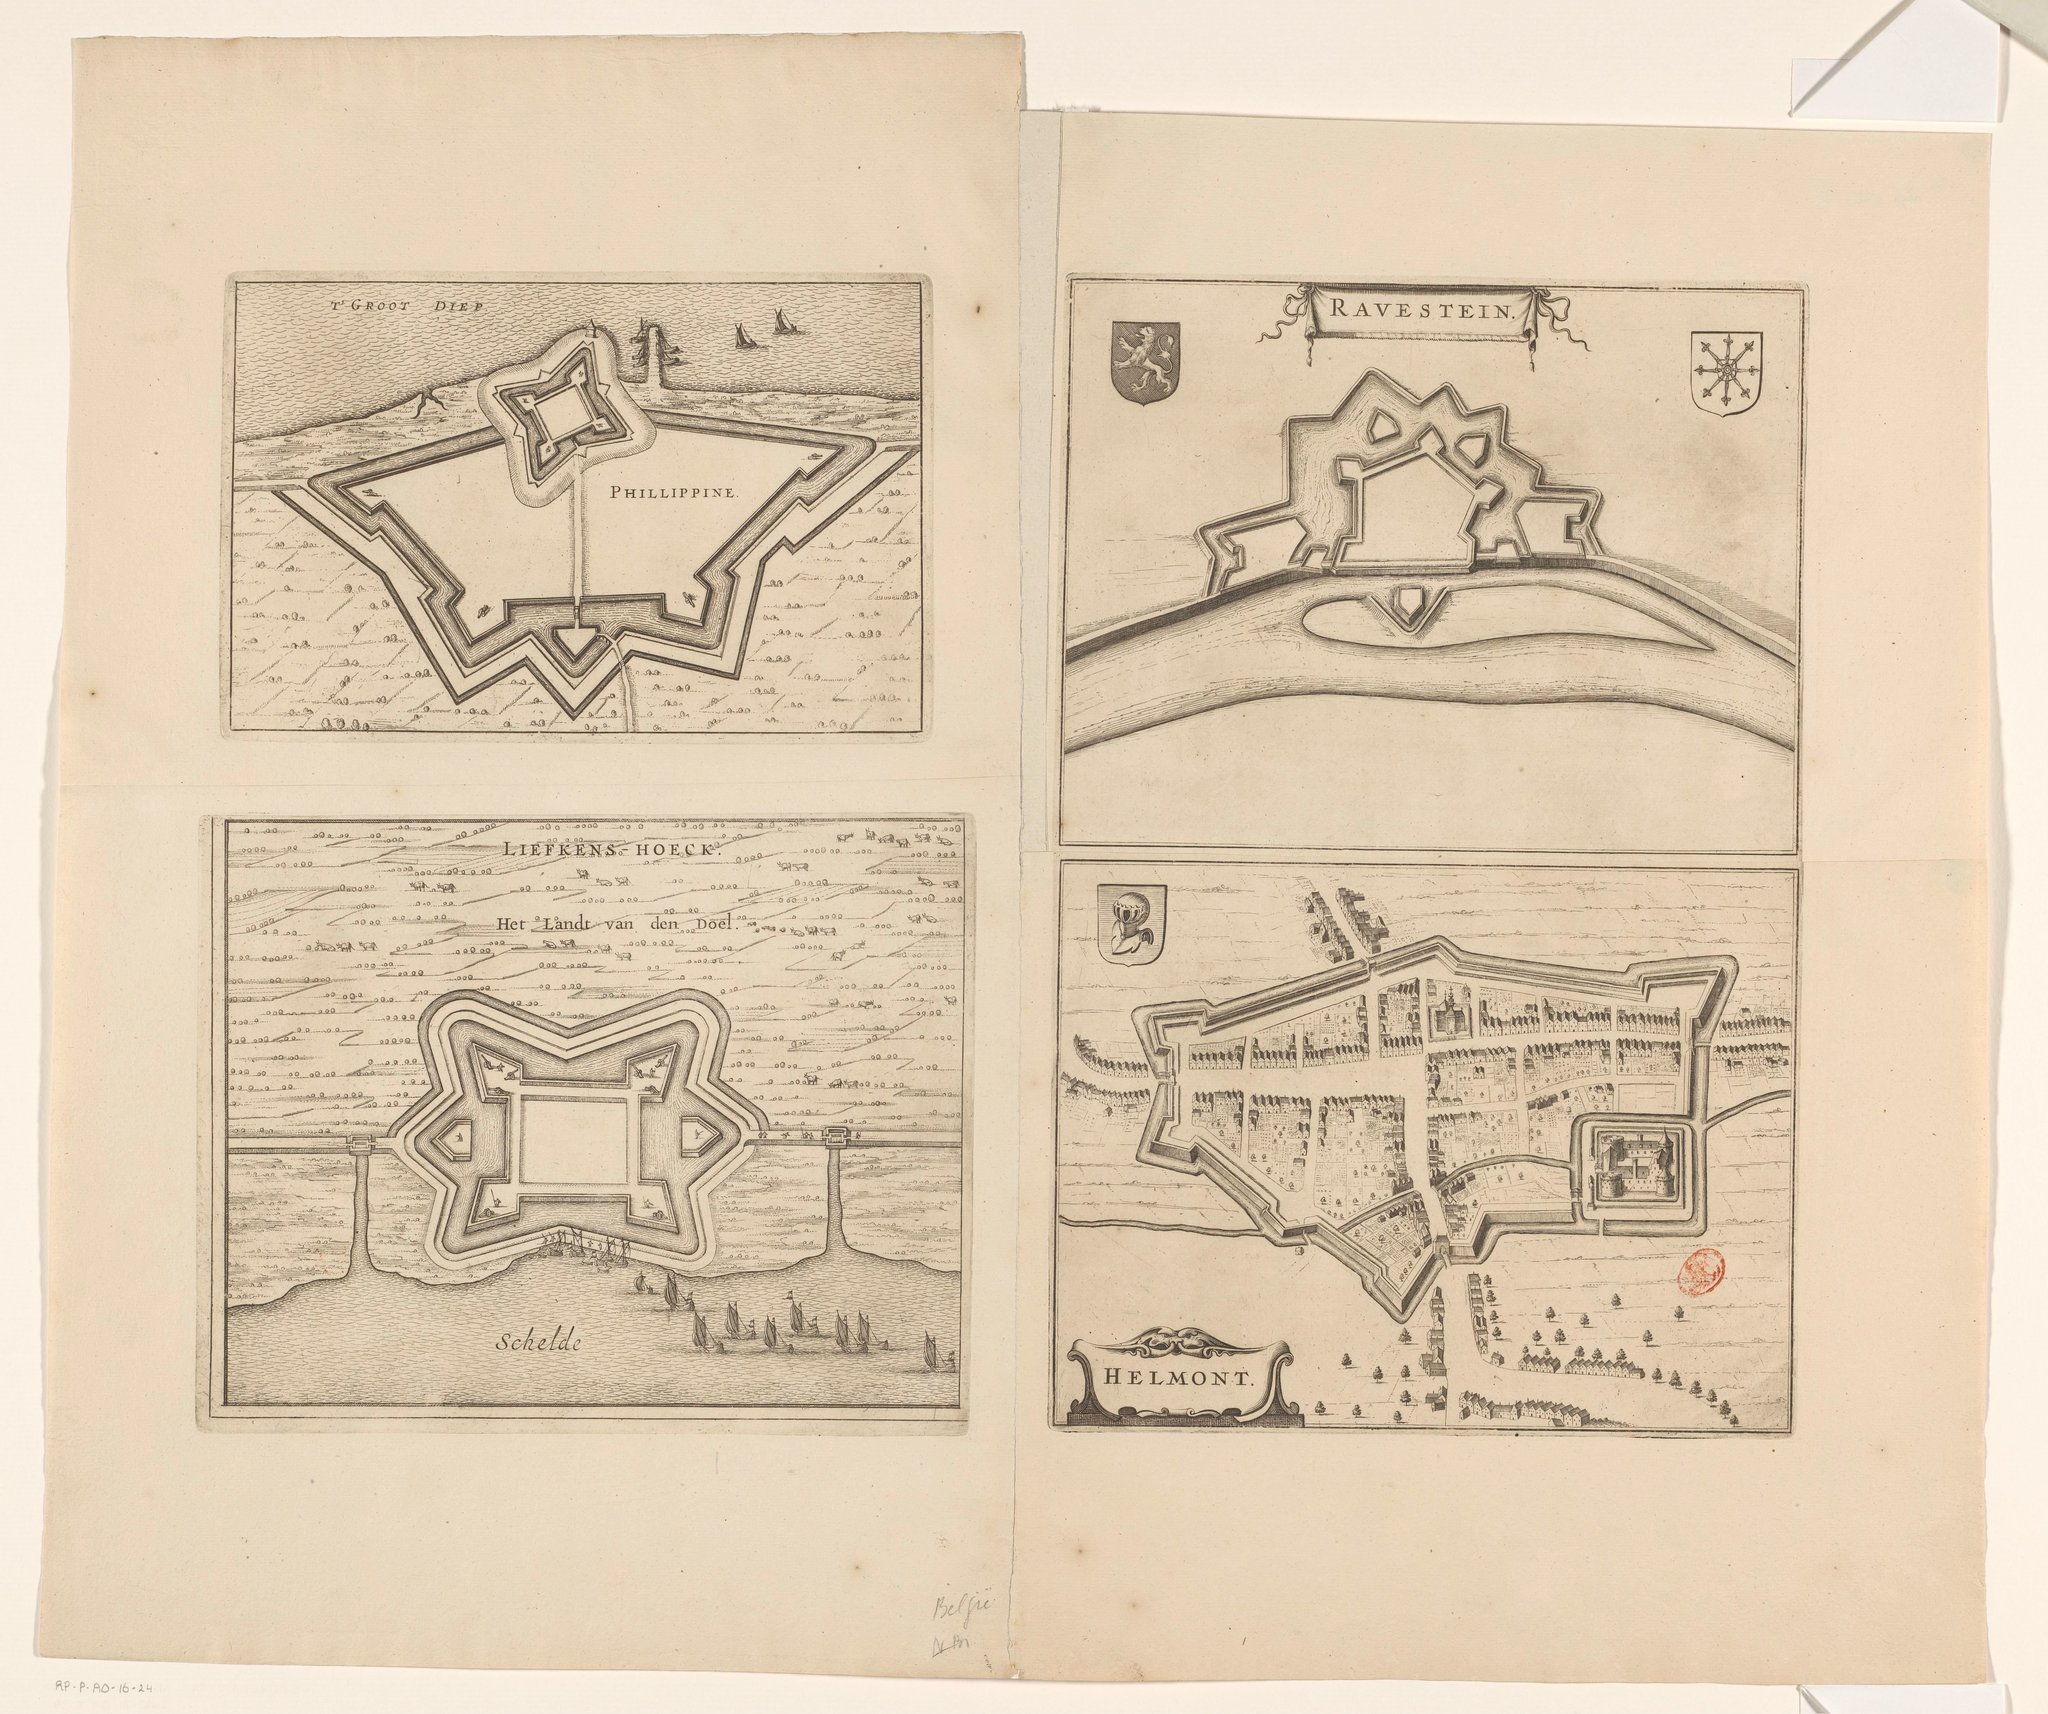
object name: area plan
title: Phillippine / Liefkens-Hoeck / Ravestein / Helmont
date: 1649-1652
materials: paper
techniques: engraving, etching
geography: amsterdam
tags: fortress, coat of arms (as symbol of the state, etc.) (+ city; municipal), maps of cities, coat of arms (as symbol of the state, etc.) (+ province; provincial)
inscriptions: collector's mark: Lugt 195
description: Alle platen zijn eerder verschenen in Stedenboeken van Blaeu (1649-1652). In Blaeu’s Stedenboeken zijn de plattegronden van deze plaatsen echter nooit op hetzelfde blad gedrukt. Bekend is dat Frederik de Wit aan het einde van de zeventiende eeuw een groot deel van de platen van Blaeu verwierf, die hij hergebruikte in zijn stedenatlassen. Deze atlassen hadden een wisselende samenstelling. De huidige samenstelling is niet terug te vinden in literatuur, maar gezien de wisselende aard van De Wits atlassen zou het mogelijk kunnen zijn dat hij de uitgever is van dit blad.